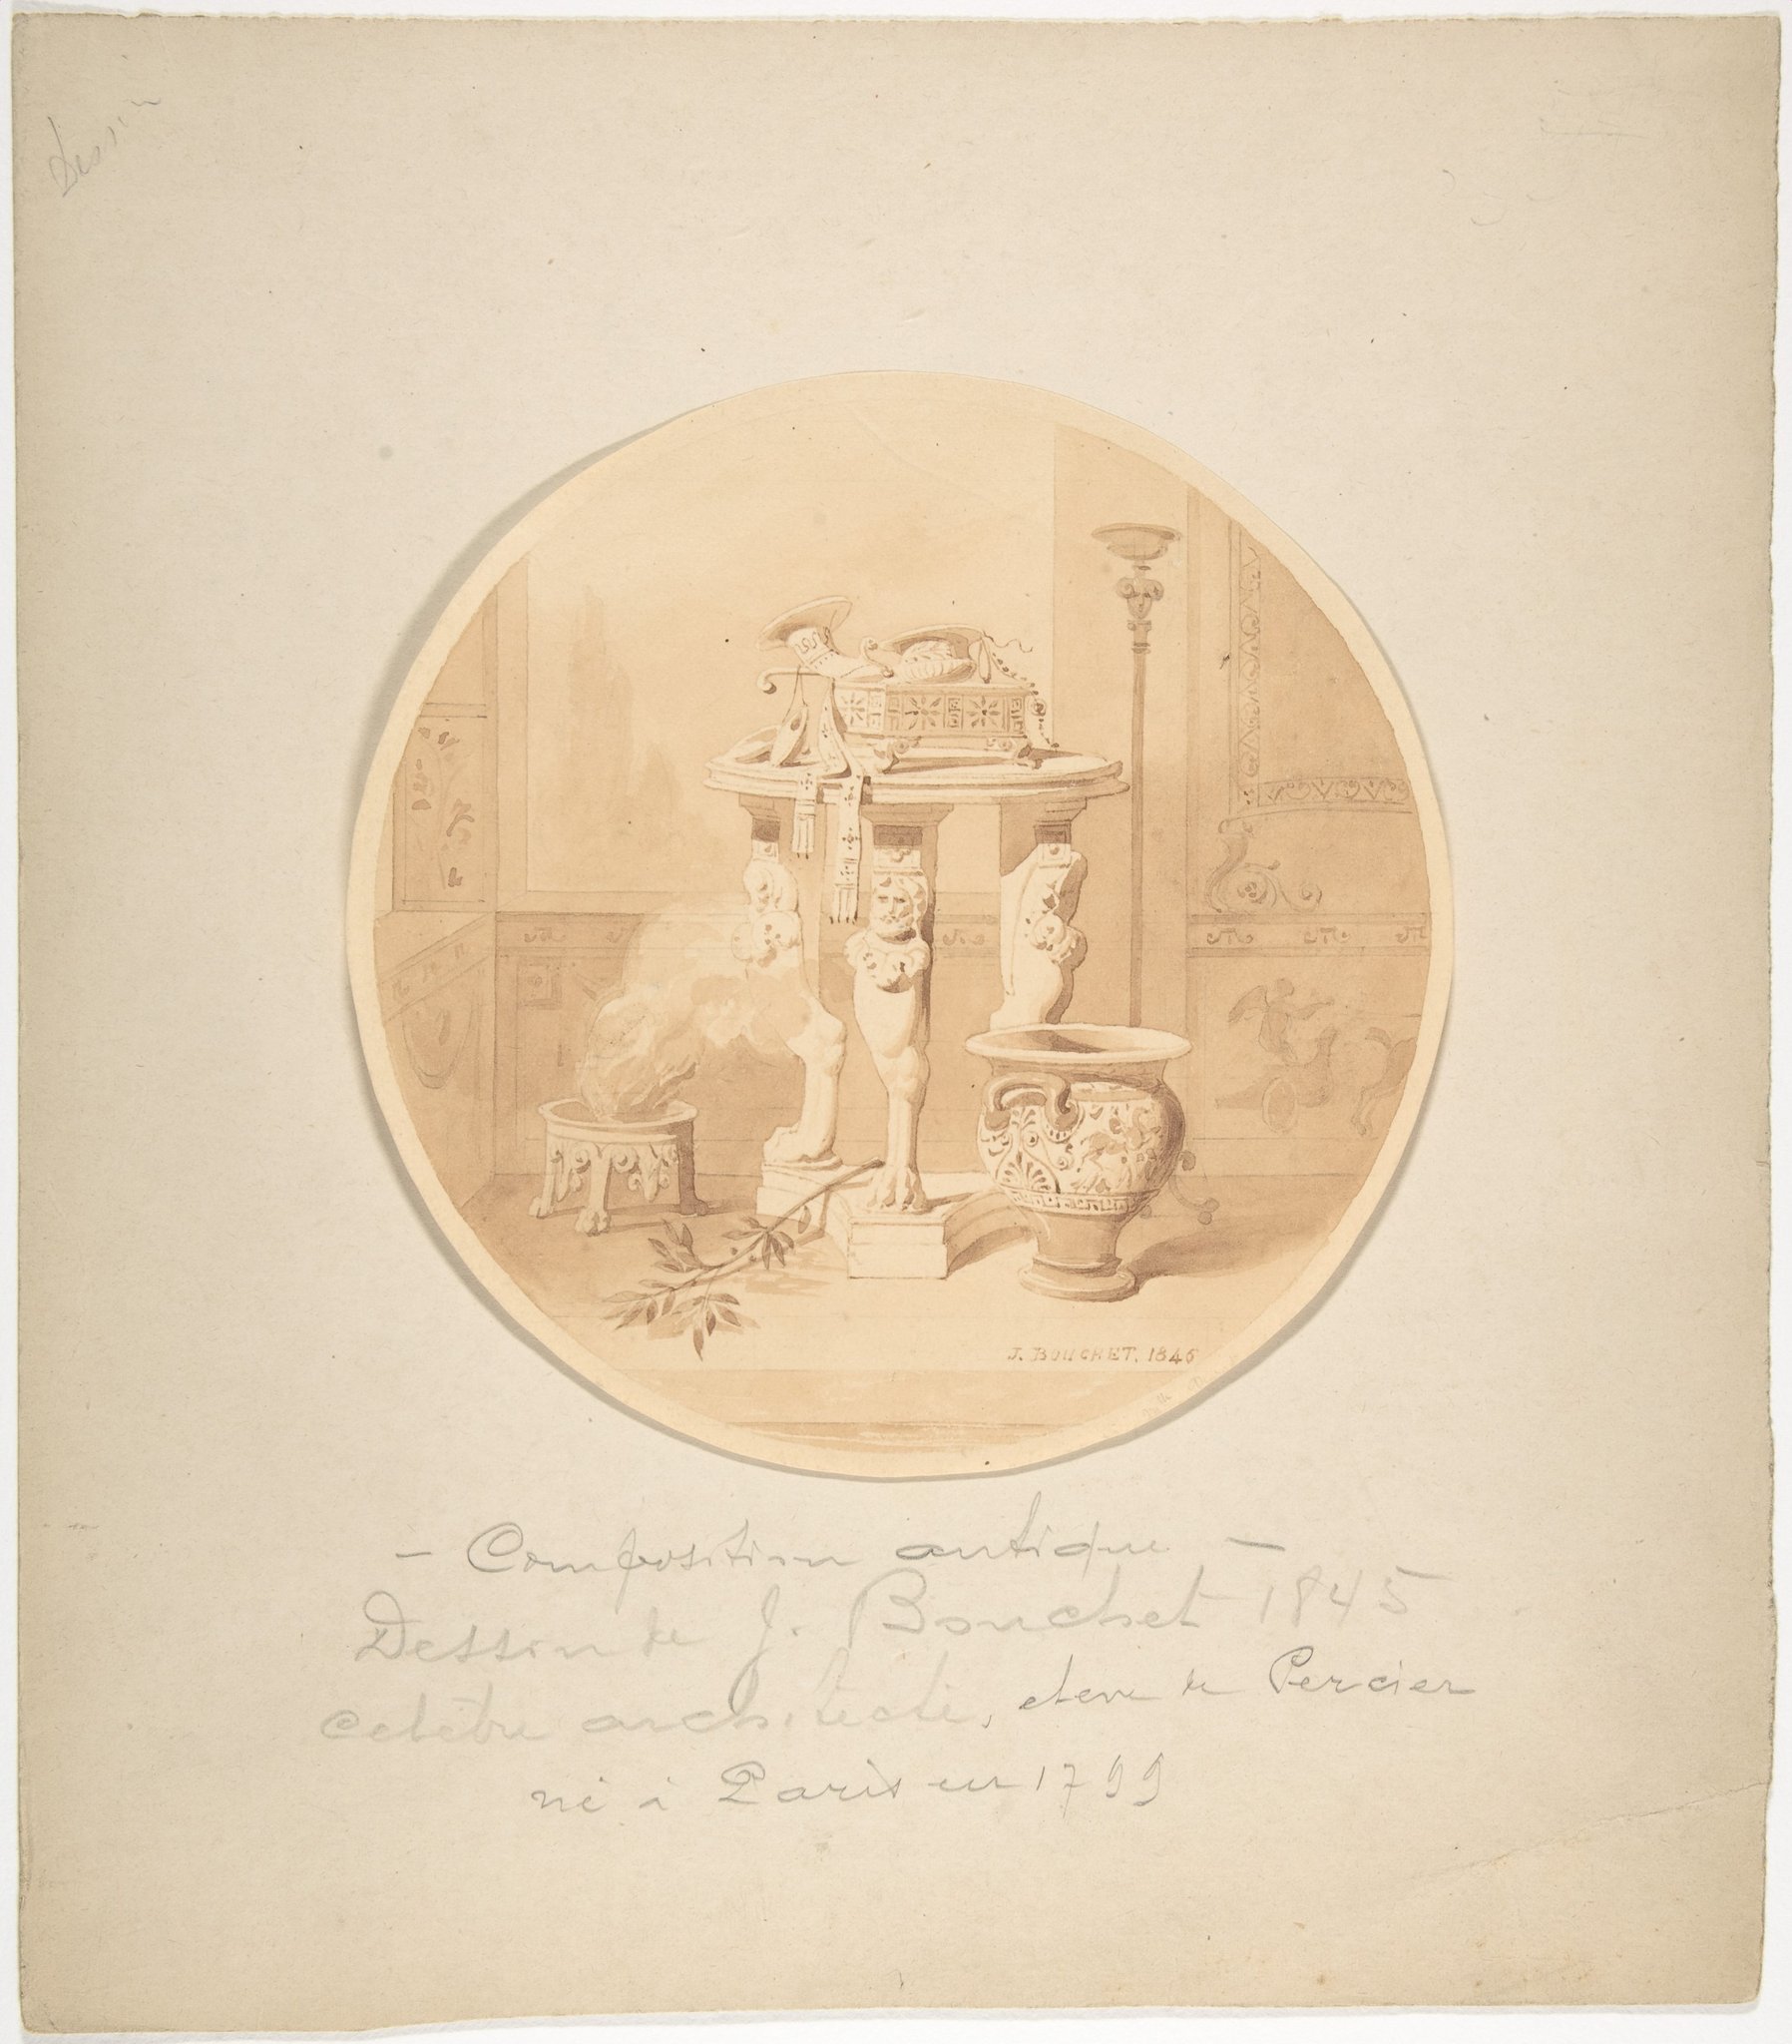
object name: drawing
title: Circular Drawing of a Classical Interior with Fire in Brazier, Greek Vase and Circular Tripod Table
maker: jules-frédéric bouchet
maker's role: artist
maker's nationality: french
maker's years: 1799-1860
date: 1801-1900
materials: graphite, ink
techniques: brush, pen, drawing, wash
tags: interiors,leaves,tables,vases